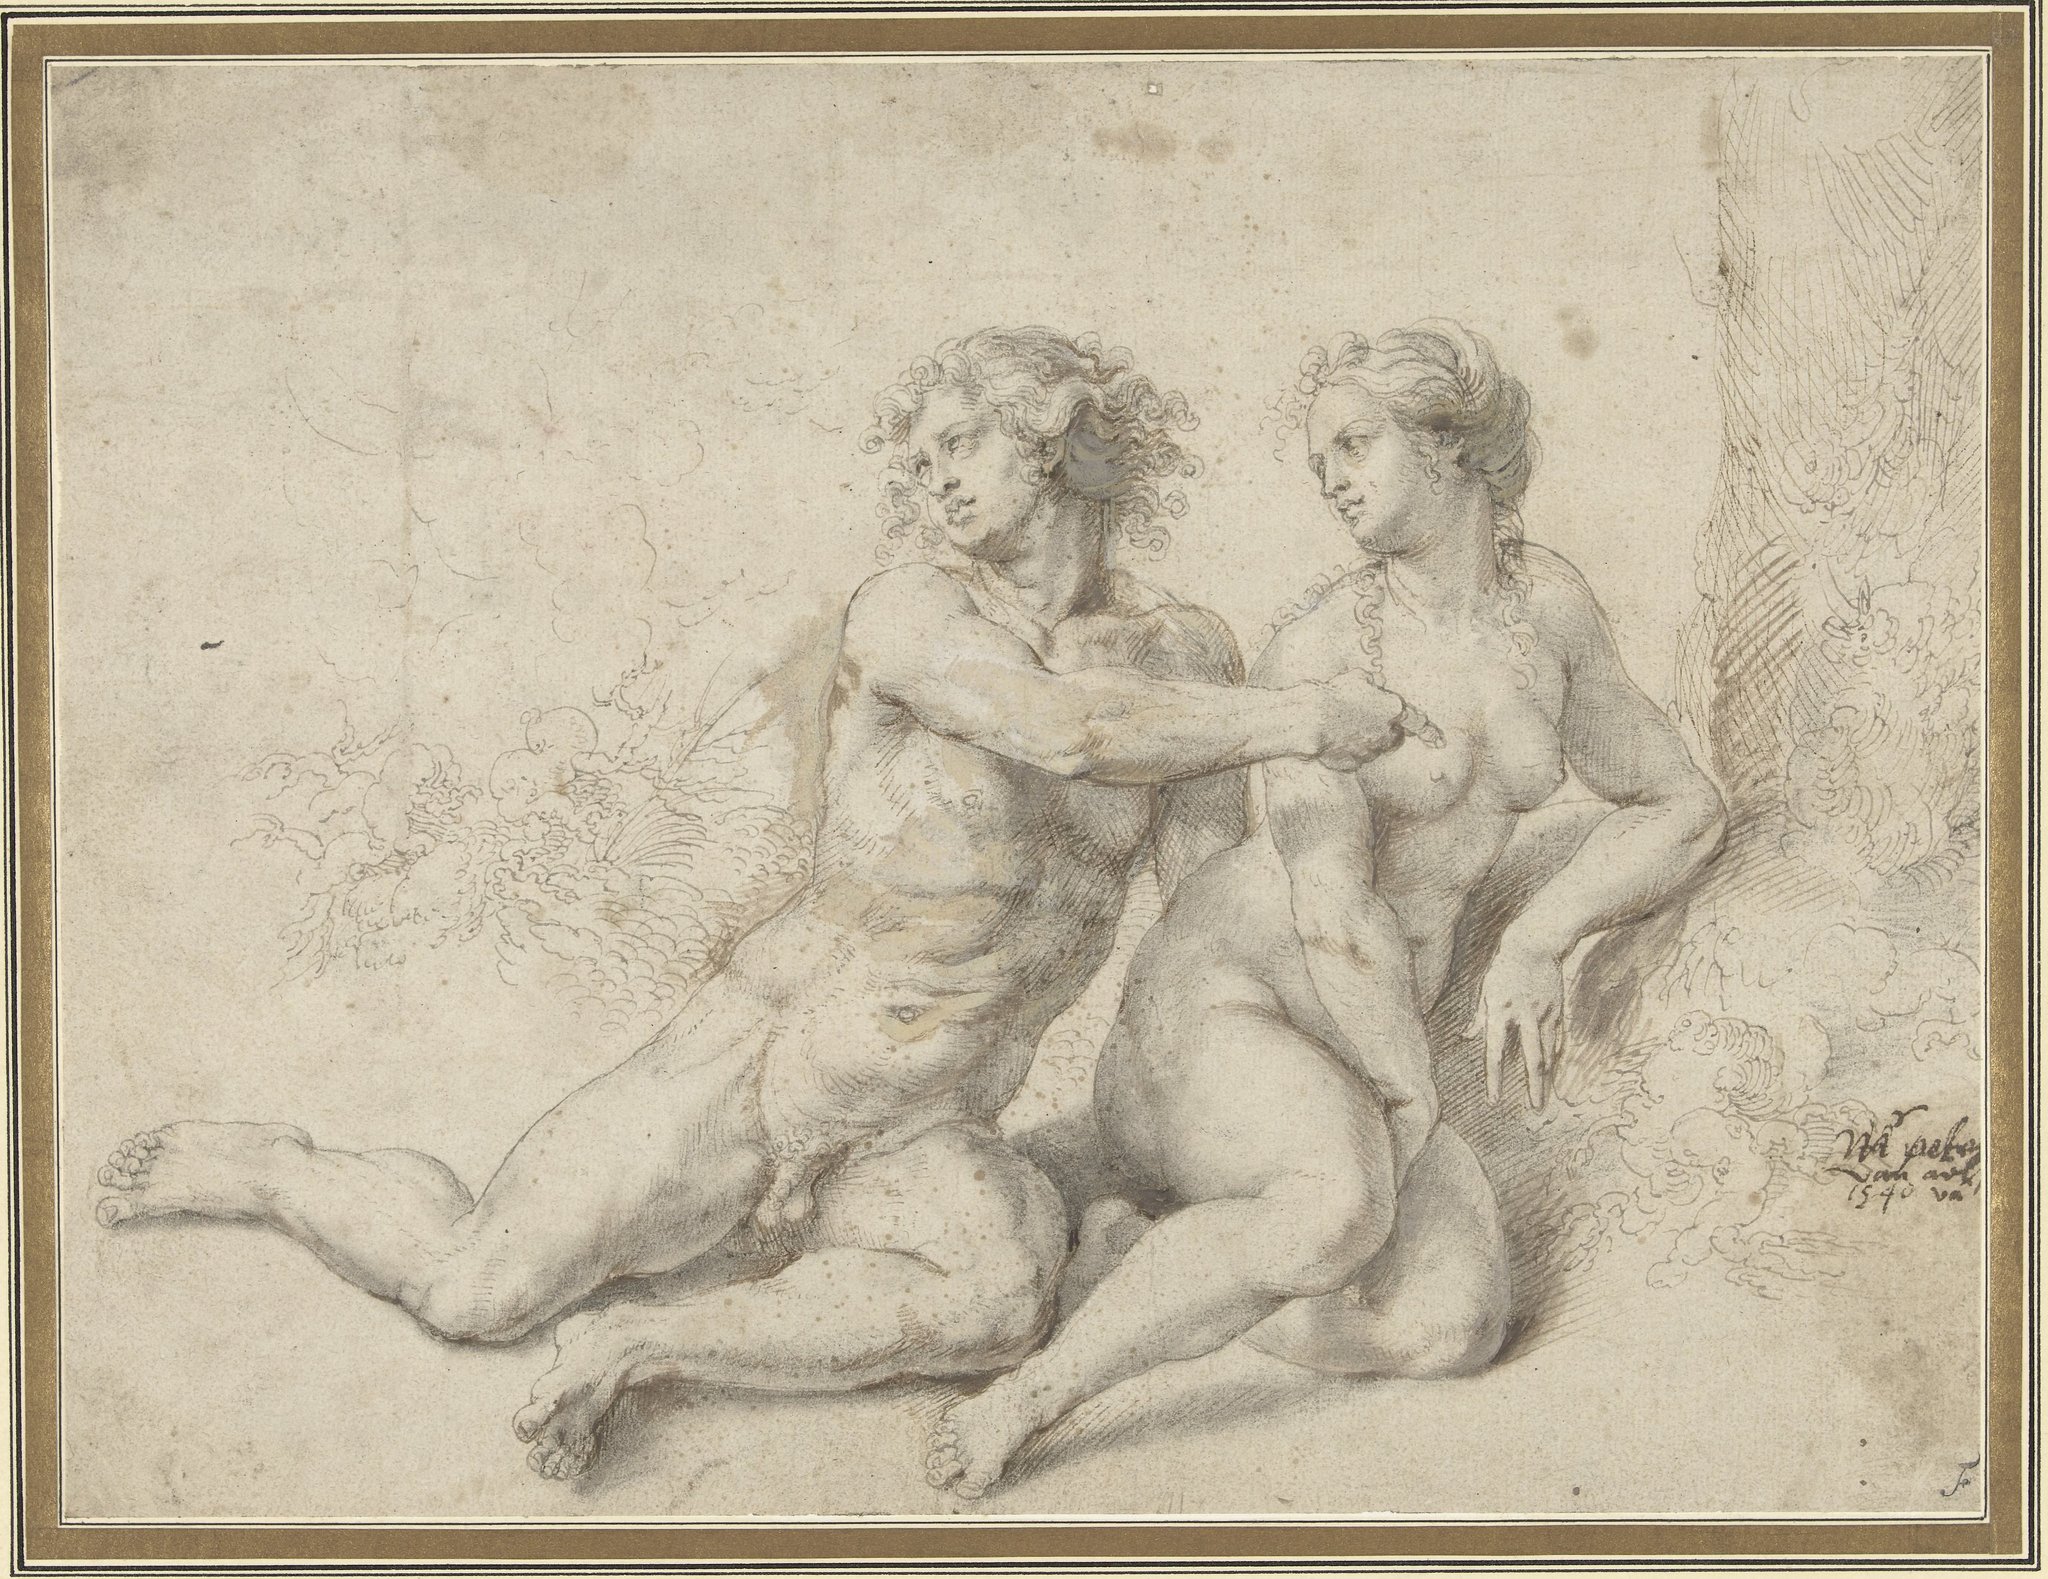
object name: drawing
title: Zondeval, Adam en Eva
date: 1540-1549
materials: ink, paint, paper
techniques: brush, pen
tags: temptation and fall (scenes with both adam and eve)